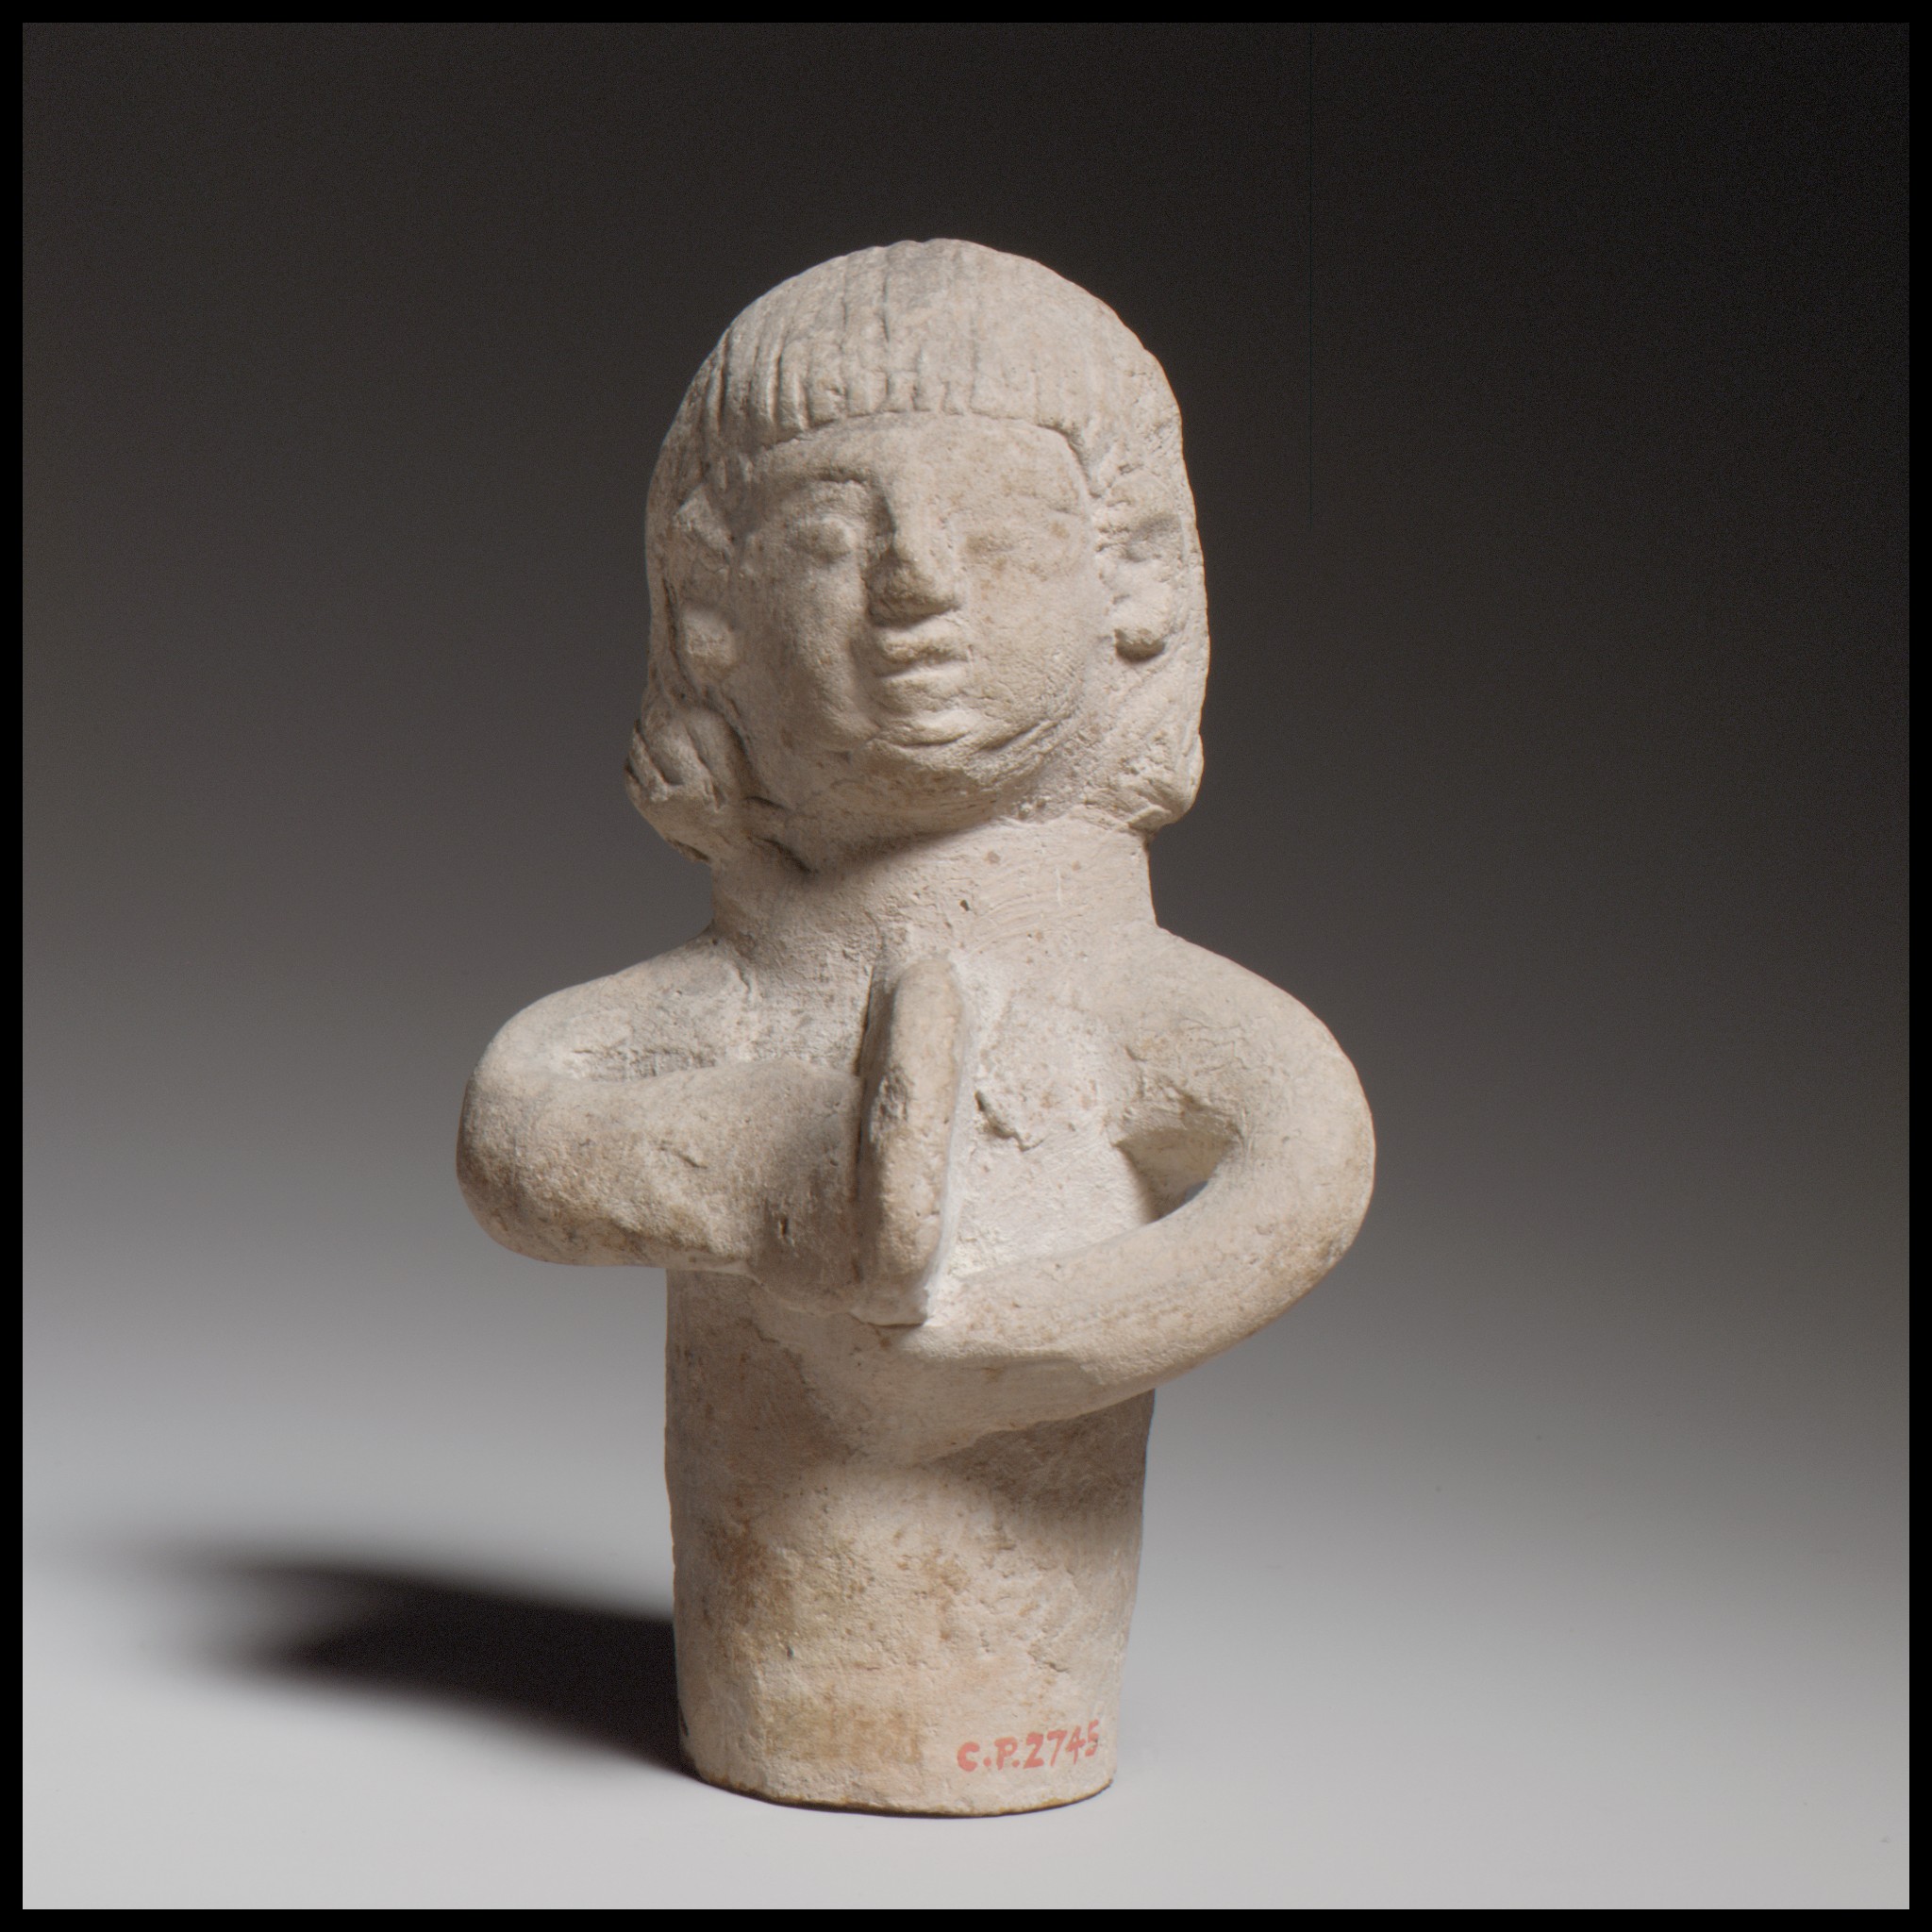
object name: statuette of a votary, female, playing tambourine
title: Standing female tambourine player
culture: cypriot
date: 600-480 BCE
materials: terracotta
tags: musical instruments,women